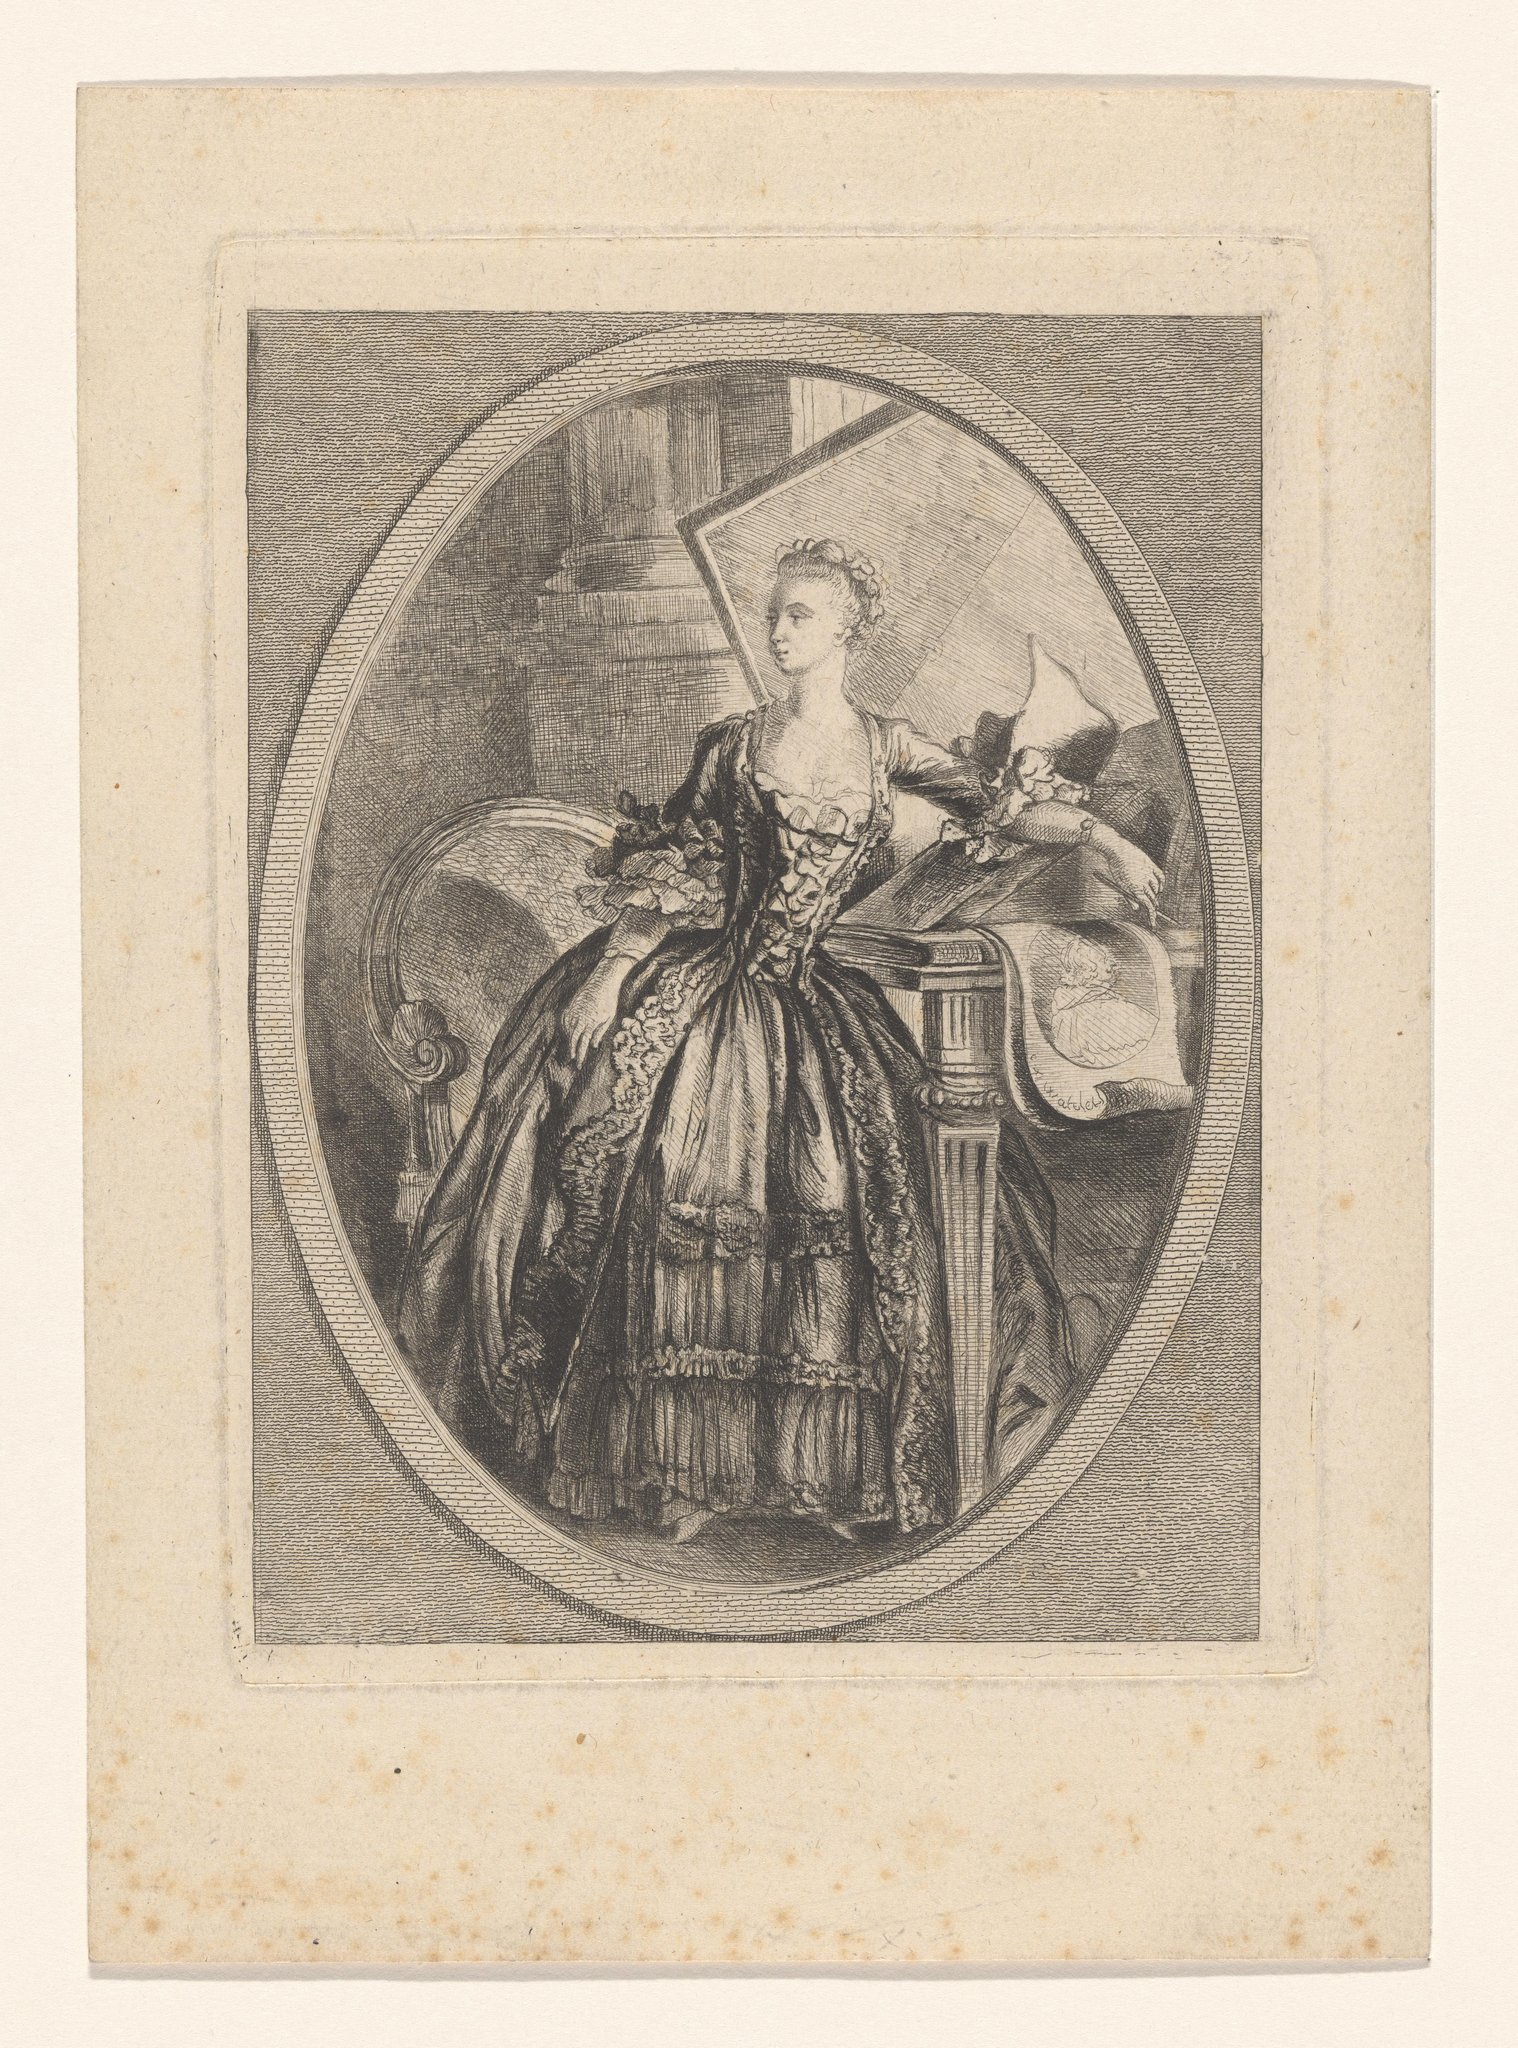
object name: print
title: Portret van Marguerite Lecomte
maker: claude henri watelet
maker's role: print maker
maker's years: 1718-1786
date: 1746-1786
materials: paper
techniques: etching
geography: paris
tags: draughtsman, historical persons - bb - woman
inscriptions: collector's mark: Lugt 2760, collector's mark: Lugt 2228, collector's mark: Lugt 5684